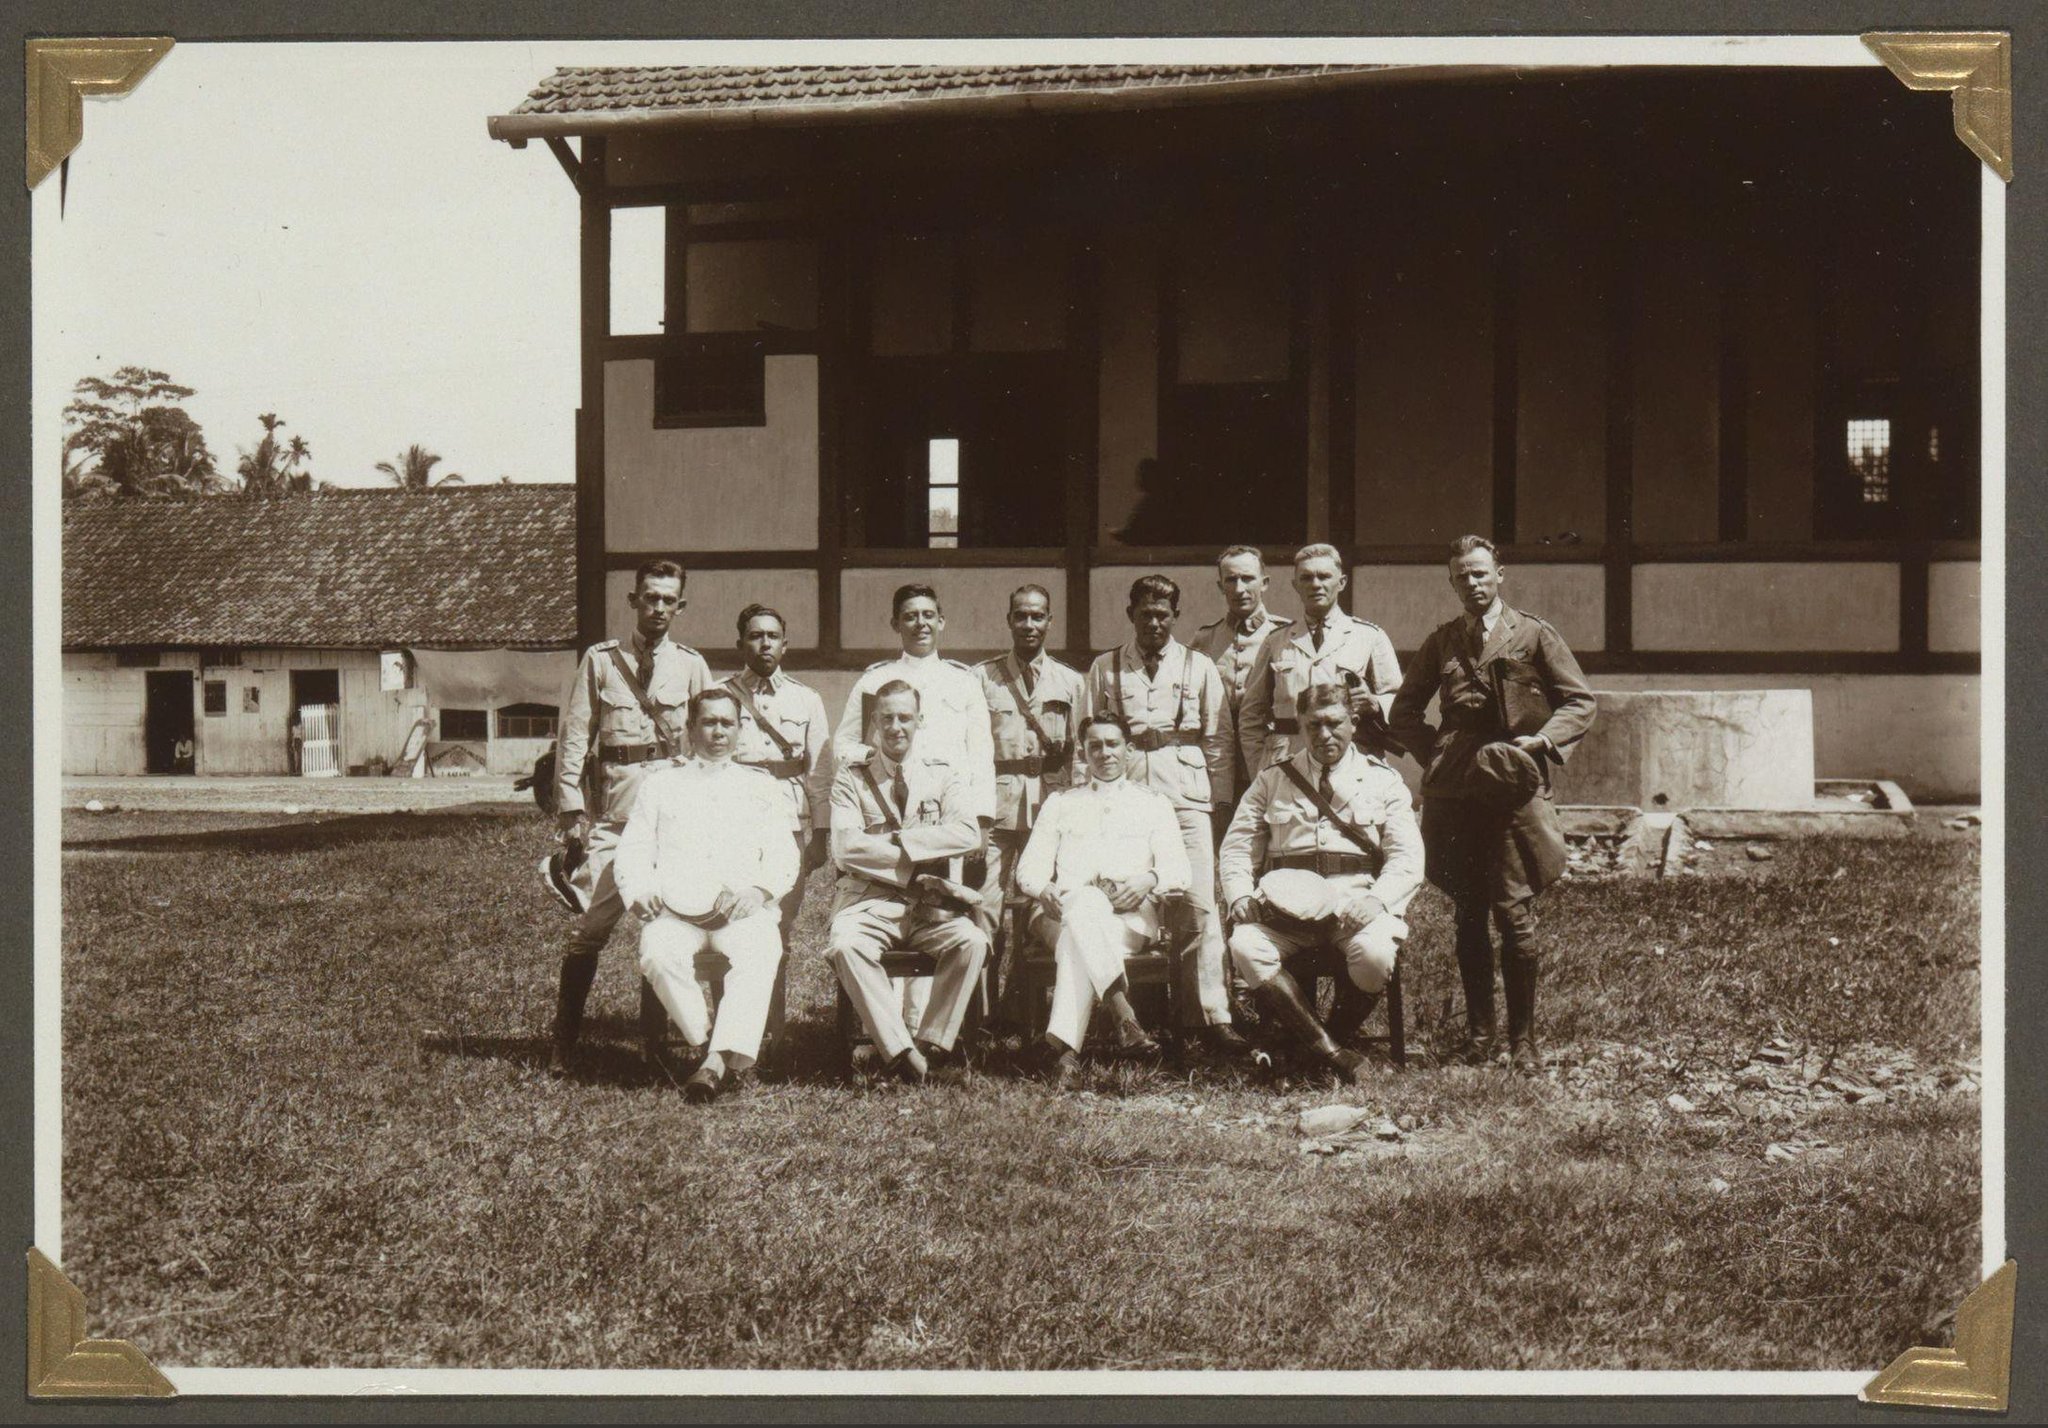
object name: photograph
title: Technische leiding en Detachementscommandanten der Veldpolitie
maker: Anonymous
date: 1932-1933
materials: photographic support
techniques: gelatin silver print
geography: lampung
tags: police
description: Onderdeel van Herinneringsalbum voor F.J. Junius, vertrekkend resident van Lampong (Zuid-Sumatra).